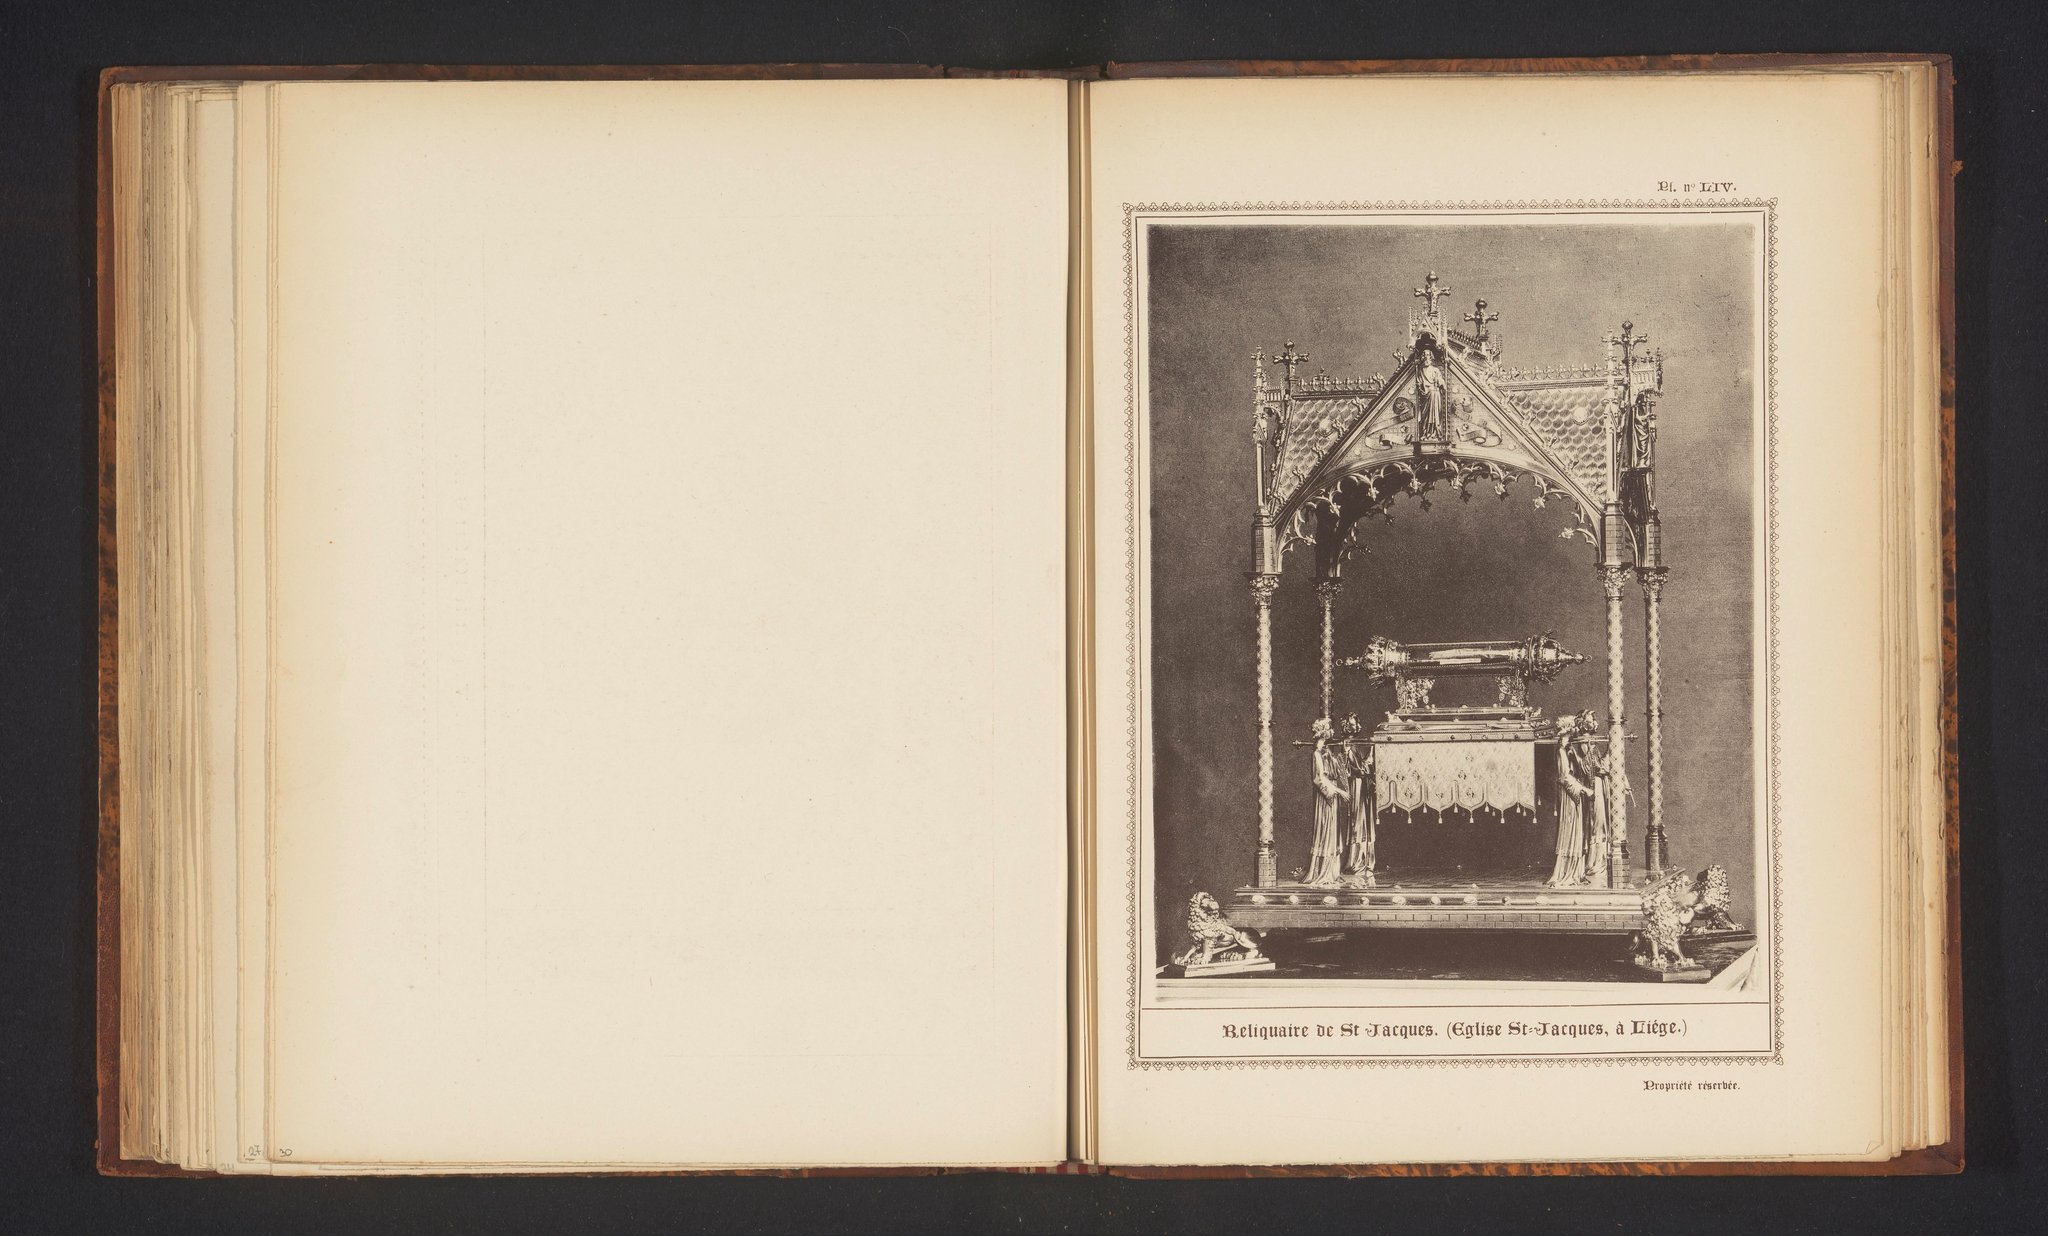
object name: photomechanical print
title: Relikwieënkast in de Sint-Jacobskerk in Luik, België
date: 1891-1896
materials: paper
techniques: photograph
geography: liège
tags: the apostle james the less, first bishop of jerusalem; possible attributes: book, fuller's club, scroll, relics (and reliquaries), interior of church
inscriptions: number: ‘Pl. no LIV.’, inscription: ‘Propriété réservée.’